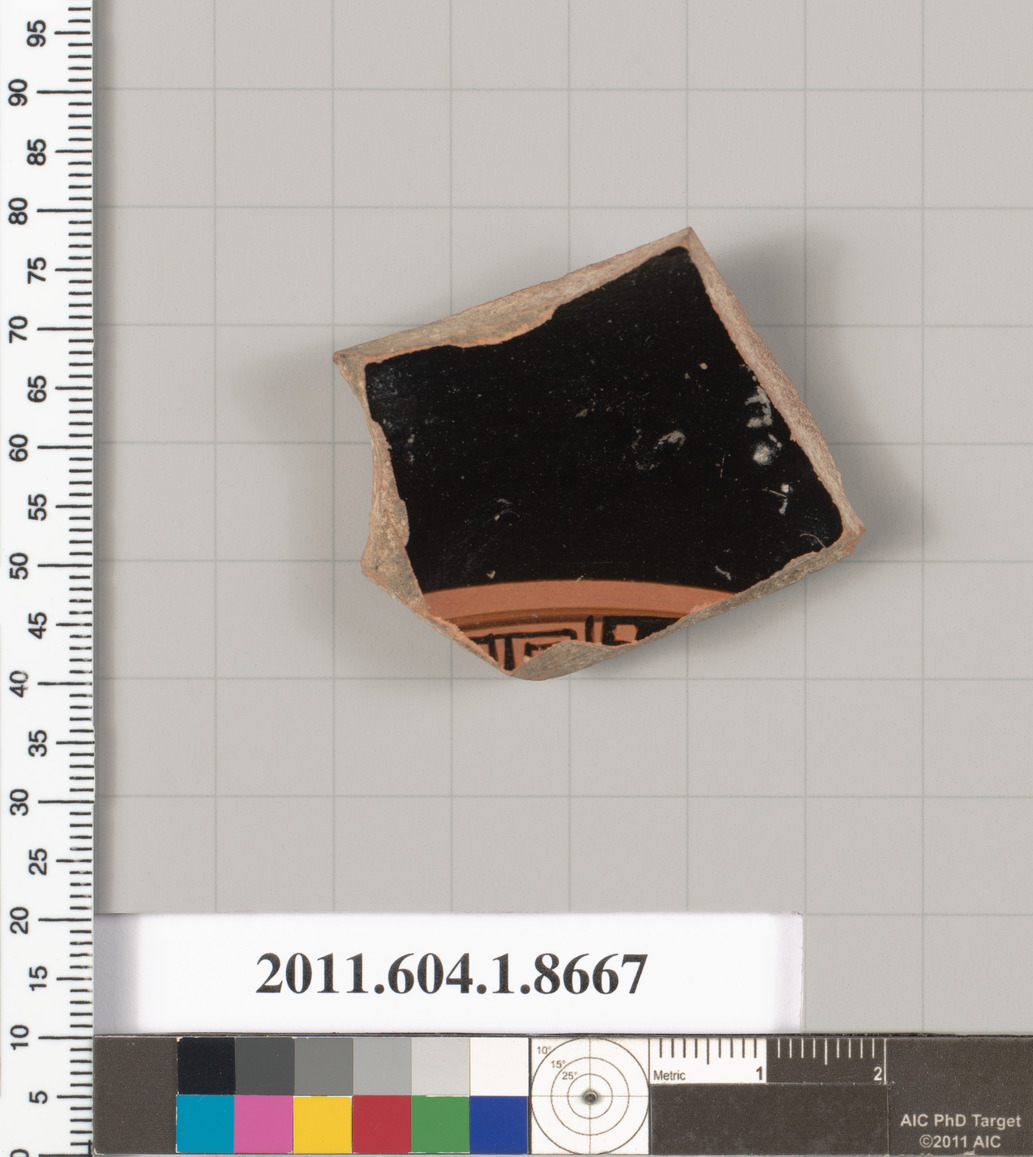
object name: kylix fragment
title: Terracotta fragment of a stemless kylix (drinking cup)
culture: greek, attic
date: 470-450 BCE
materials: terracotta